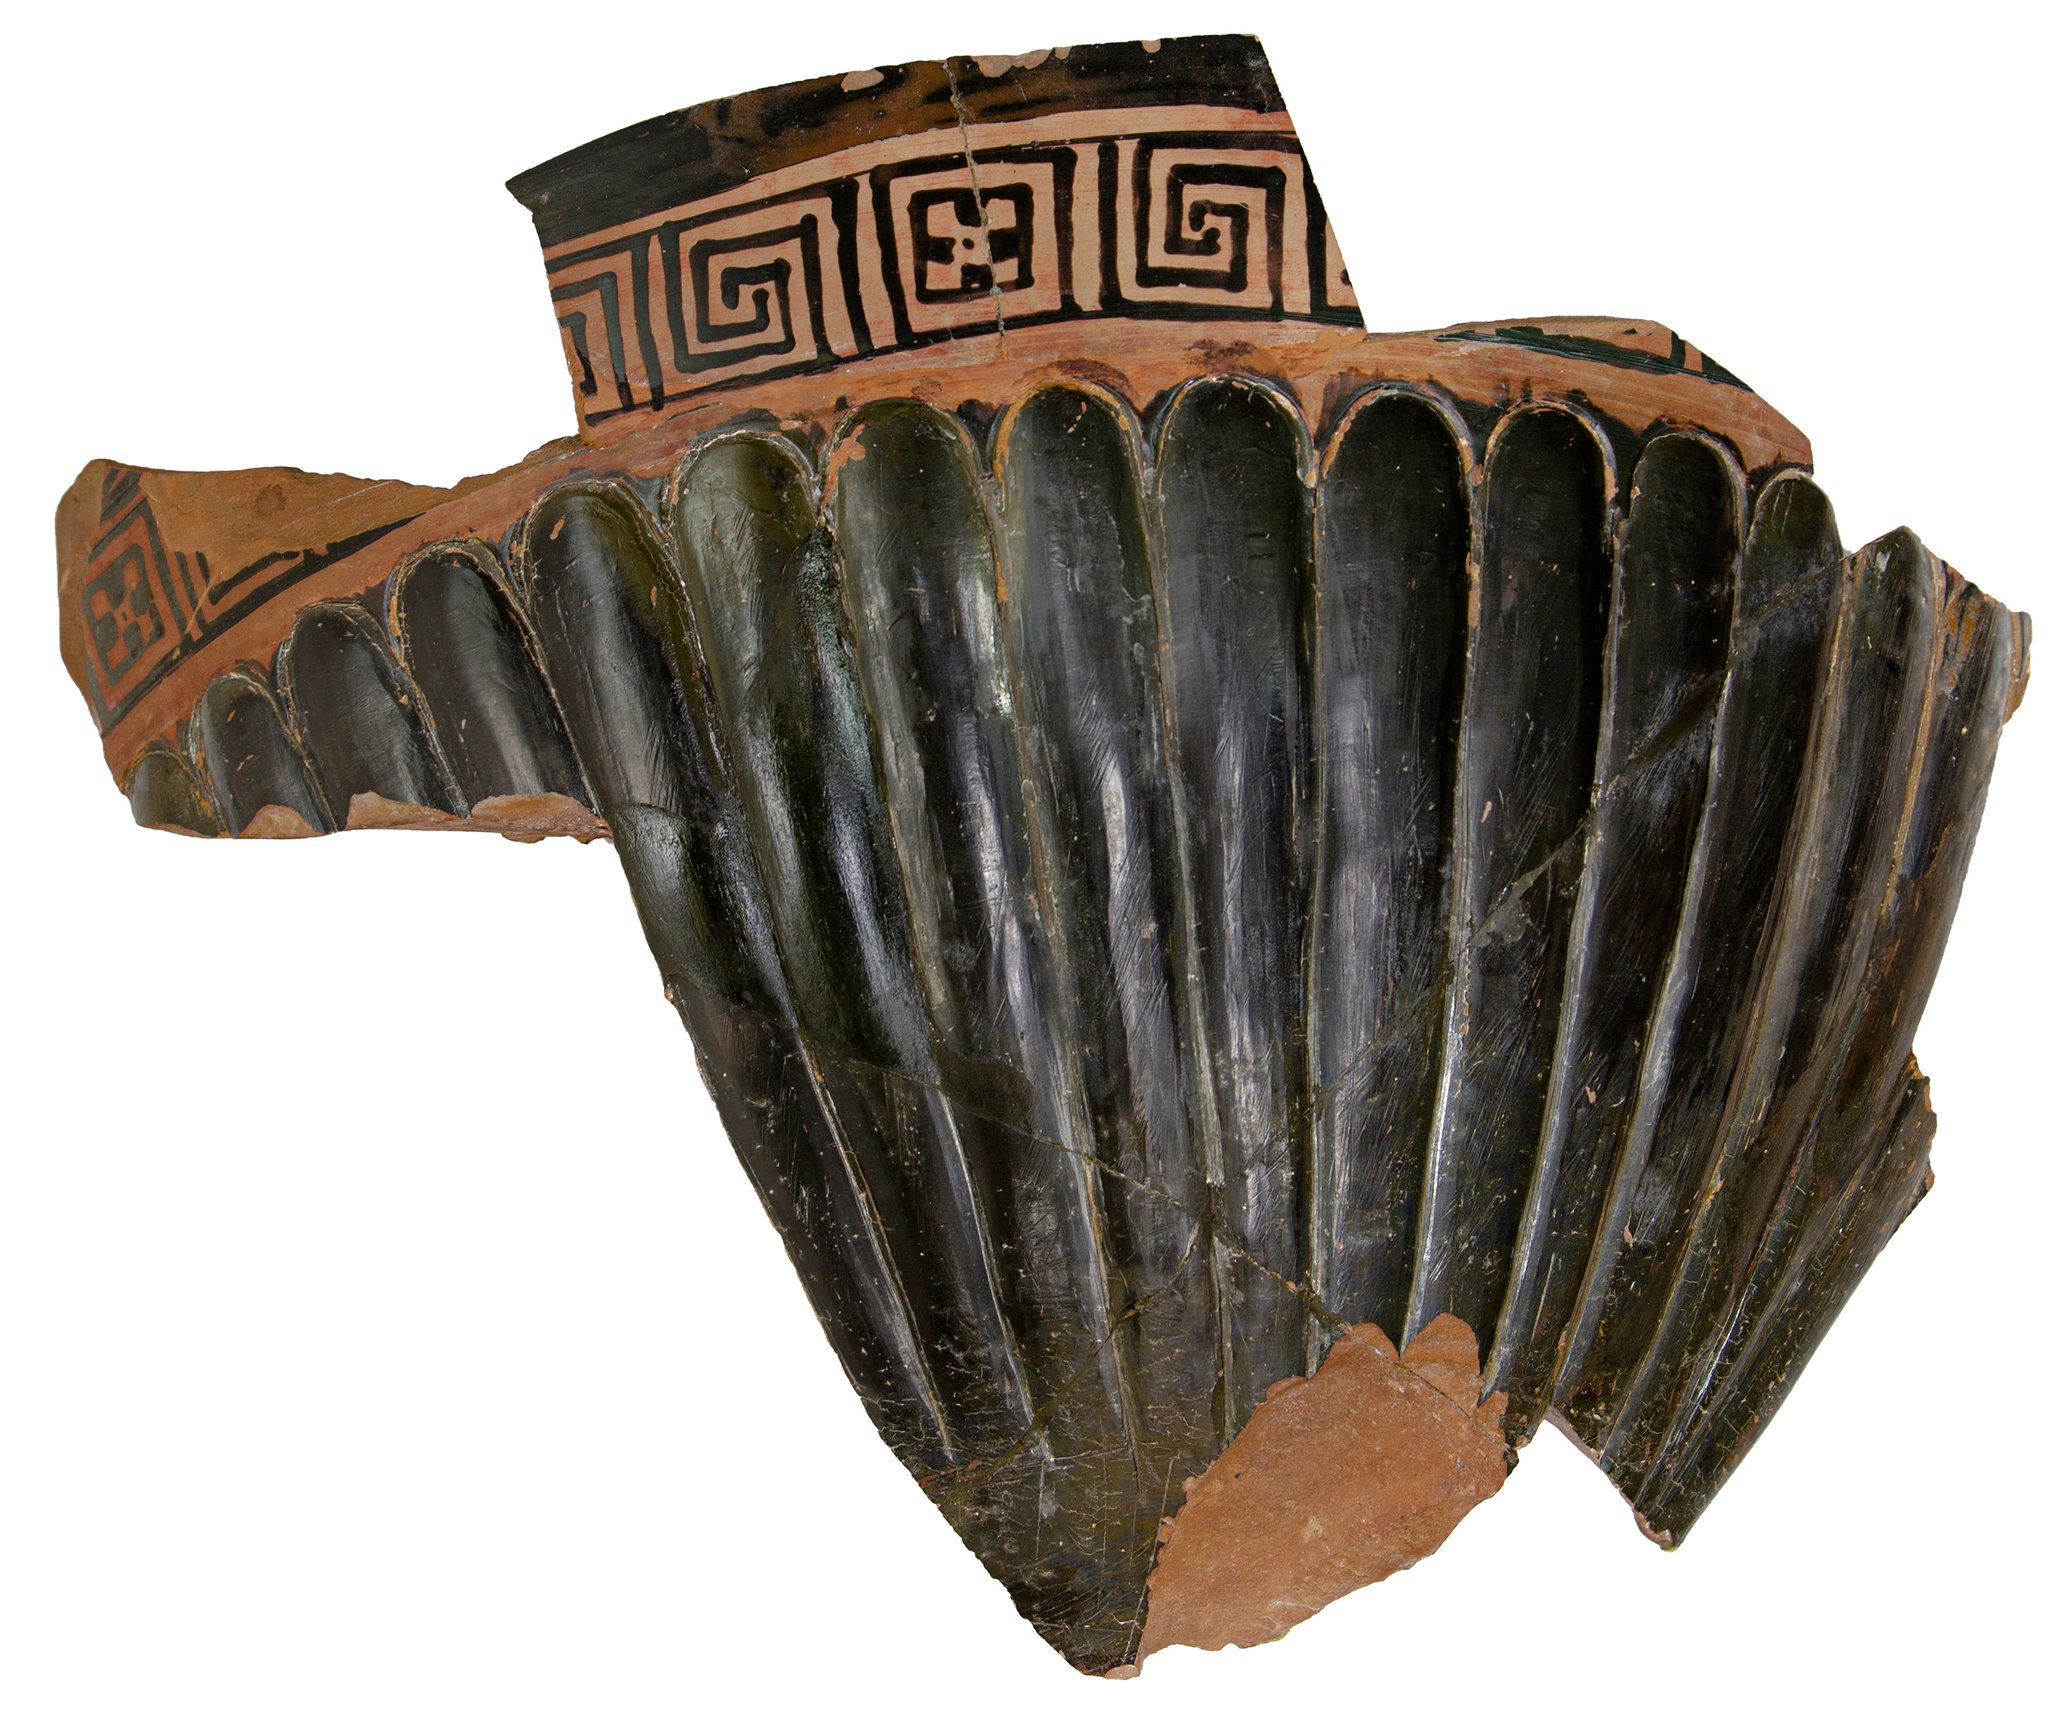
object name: volute krater fragment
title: Volute-krater fragment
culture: greek, south italian, apulian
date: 400-350 BCE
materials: terracotta